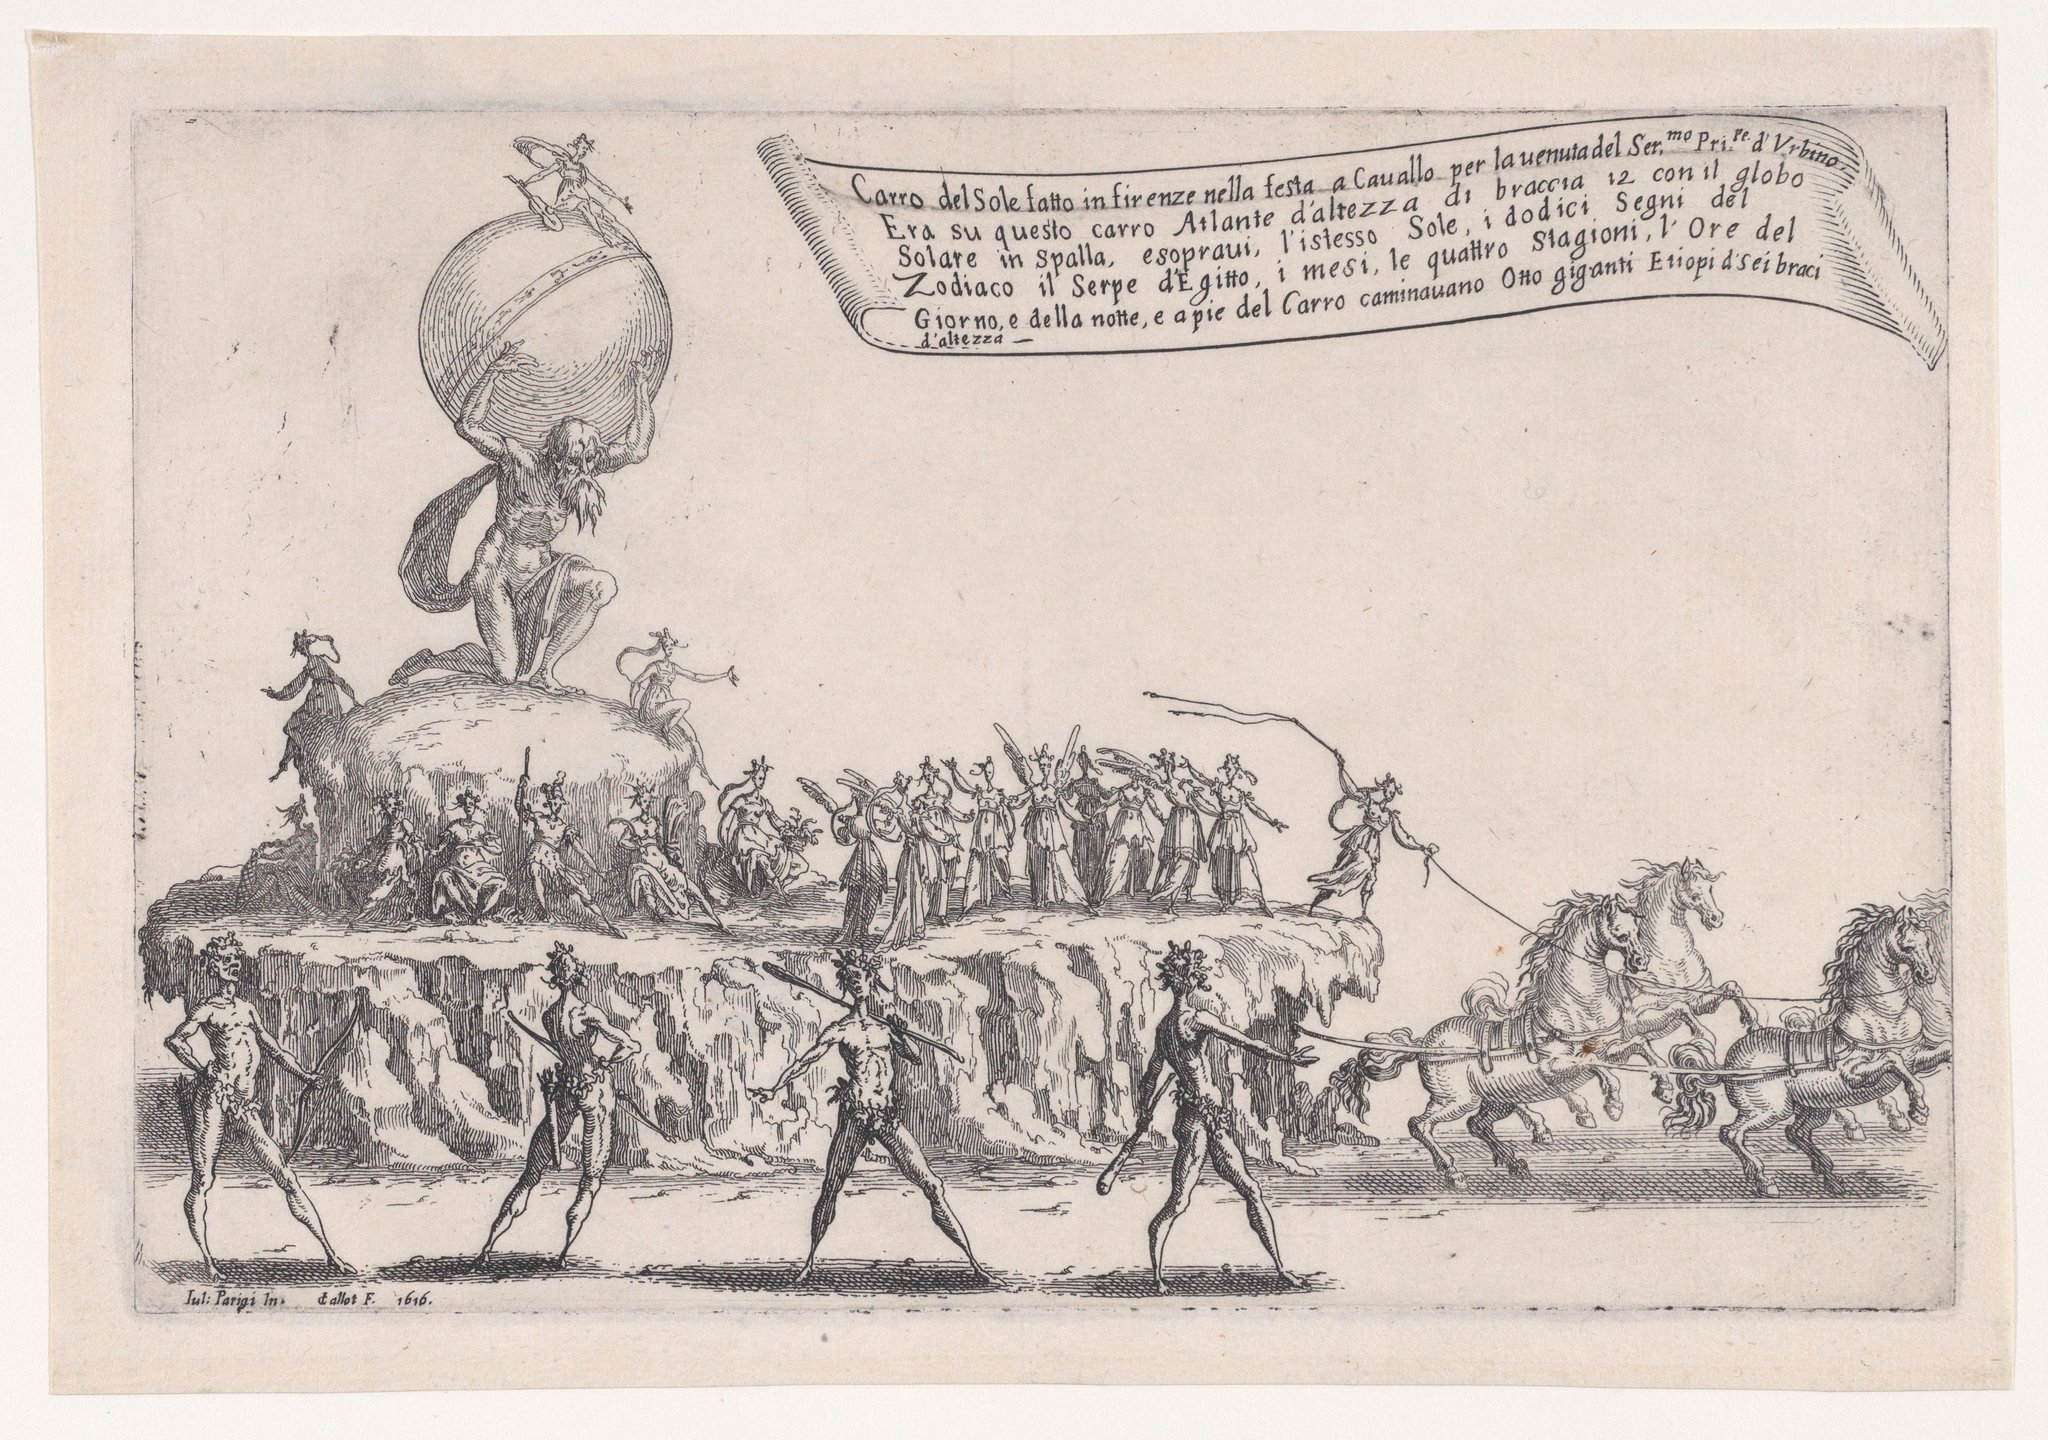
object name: print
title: Le Char du Soleil (The Chariot of Sun), from "Guerre de Beauté" (Guerra di Bellezza) (War of Beauty)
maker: jacques callot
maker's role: artist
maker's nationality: french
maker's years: 1592-1635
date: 1616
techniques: etching